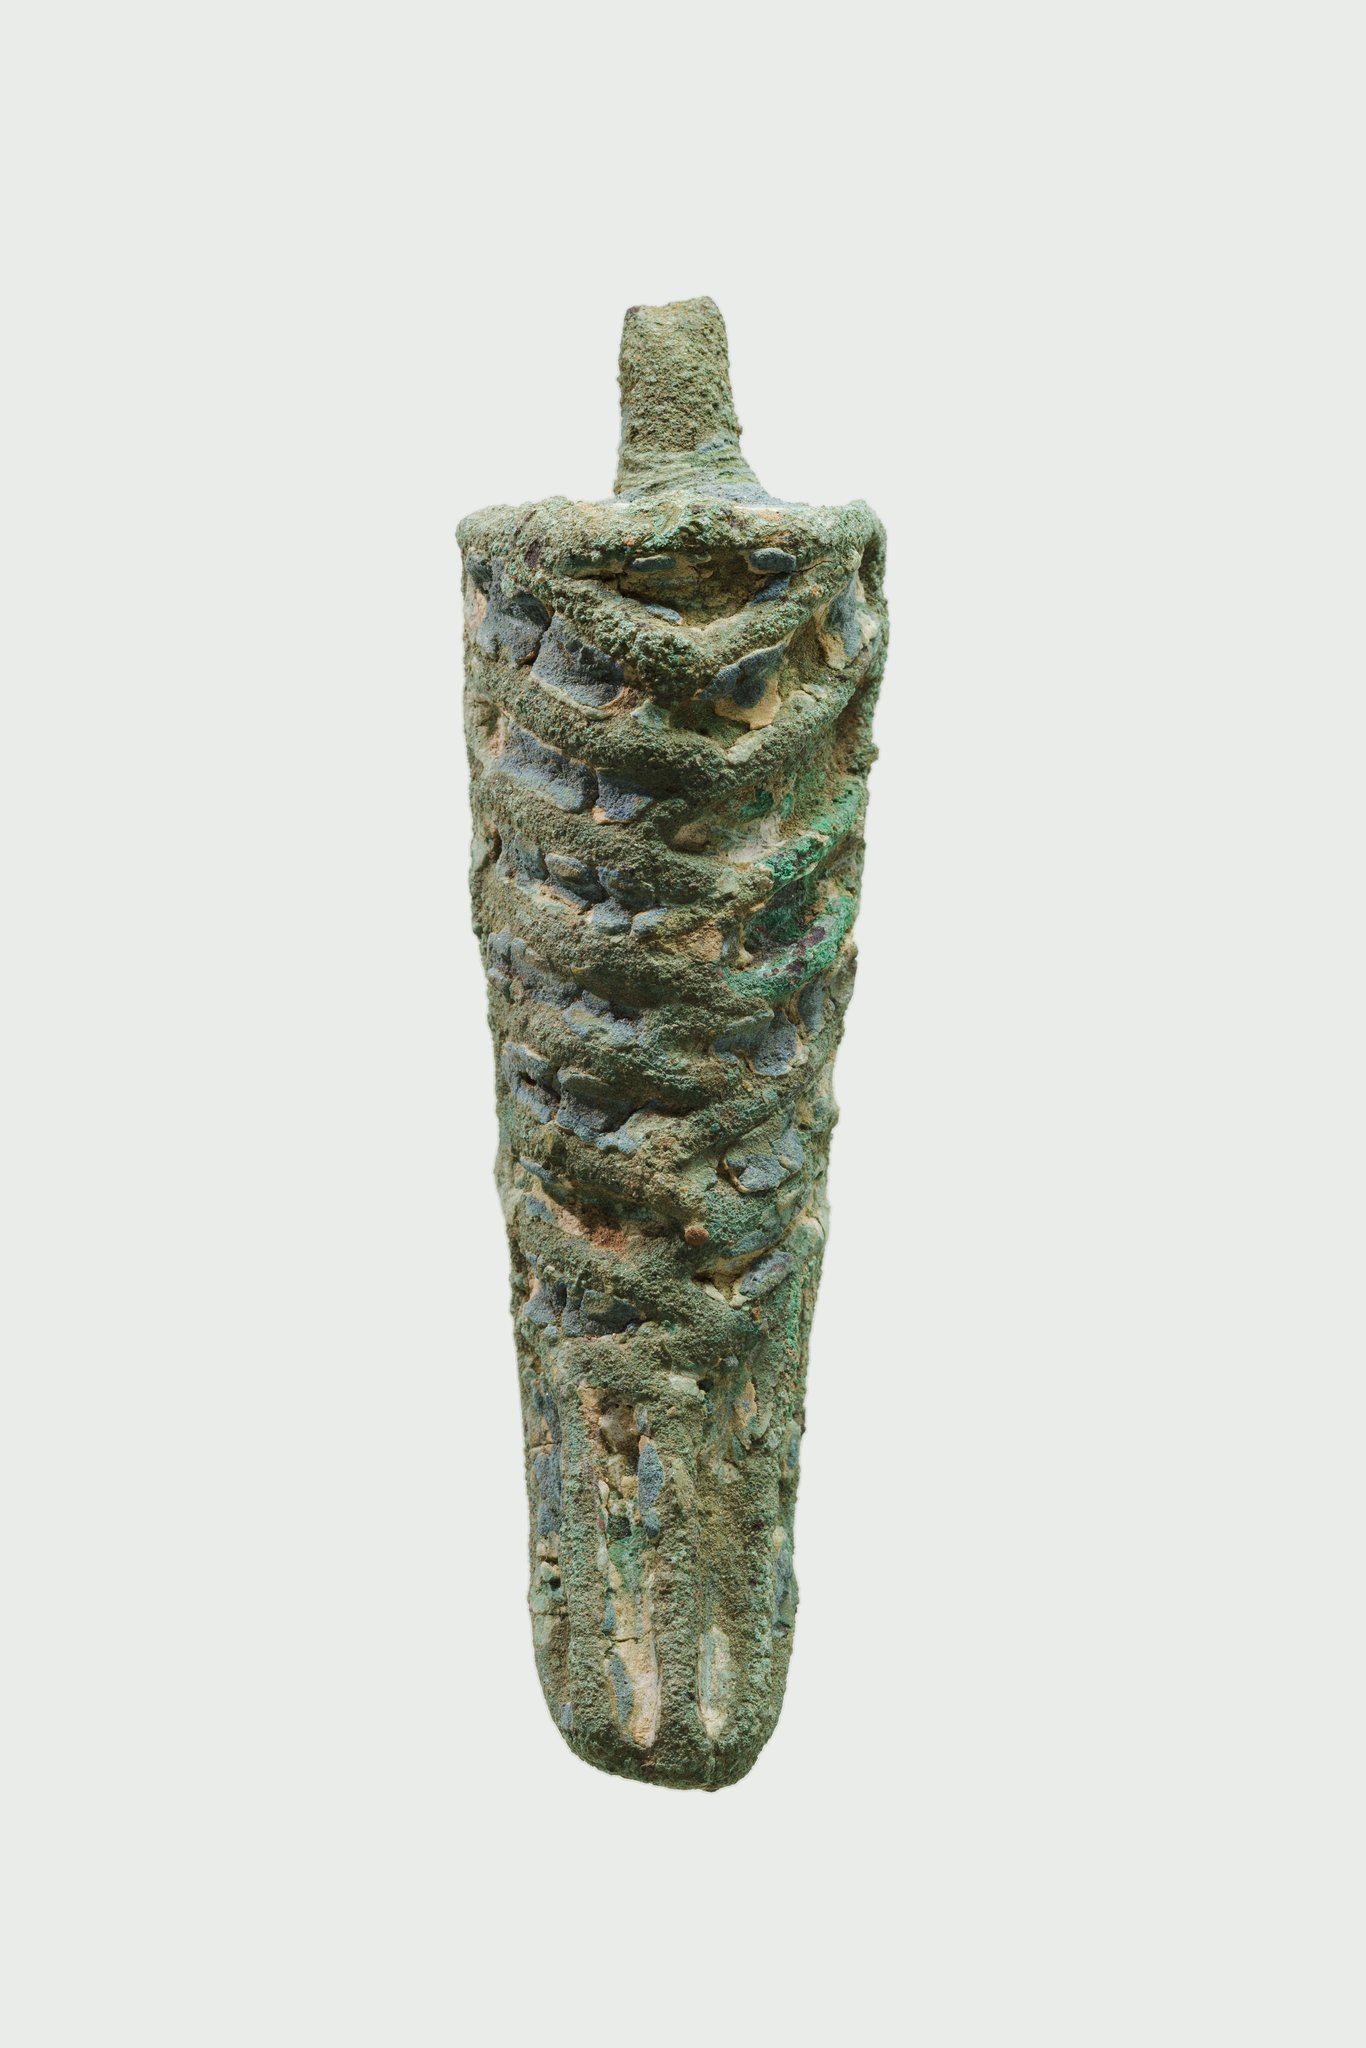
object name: statuette, beard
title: Beard for a statue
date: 712-30 BCE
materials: copper alloy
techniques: inlay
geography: egypt